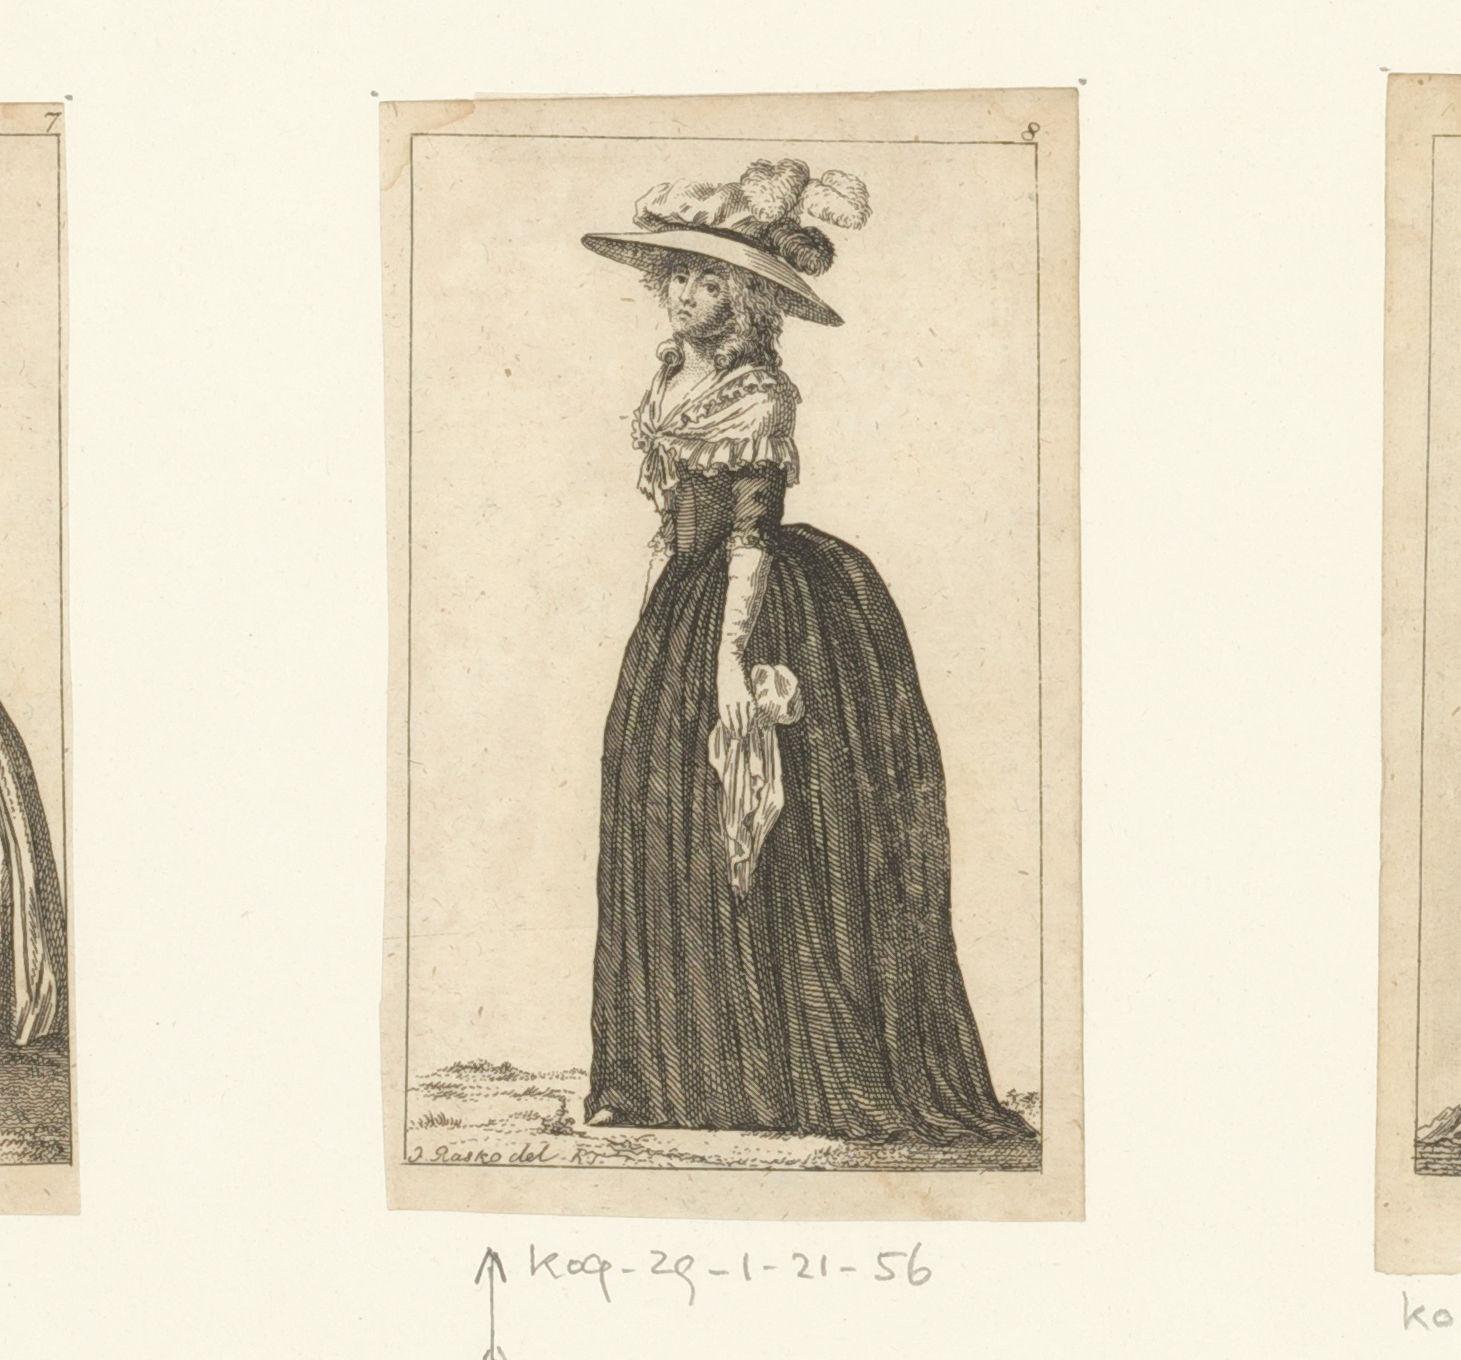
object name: print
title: Staande dame met hoed en zakdoek in haar hand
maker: j. rasko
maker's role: draughtsman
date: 1780-1840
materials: paper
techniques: etching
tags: head-gear: hat, standing figure - aa - female human figure, dress, gown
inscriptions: collector's mark: Lugt 1641, stamp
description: Rechtsboven genummerd: 8. Onderwerpsrubrieken binnen de Atlas Zeden en Gewoonten: Zeden en Gewoonten in Engeren Zin, De Kleeding, Kleederdrachten (tijdvakken), De 18de eeuw (de pruikentijd). Mannen en vrouwen.